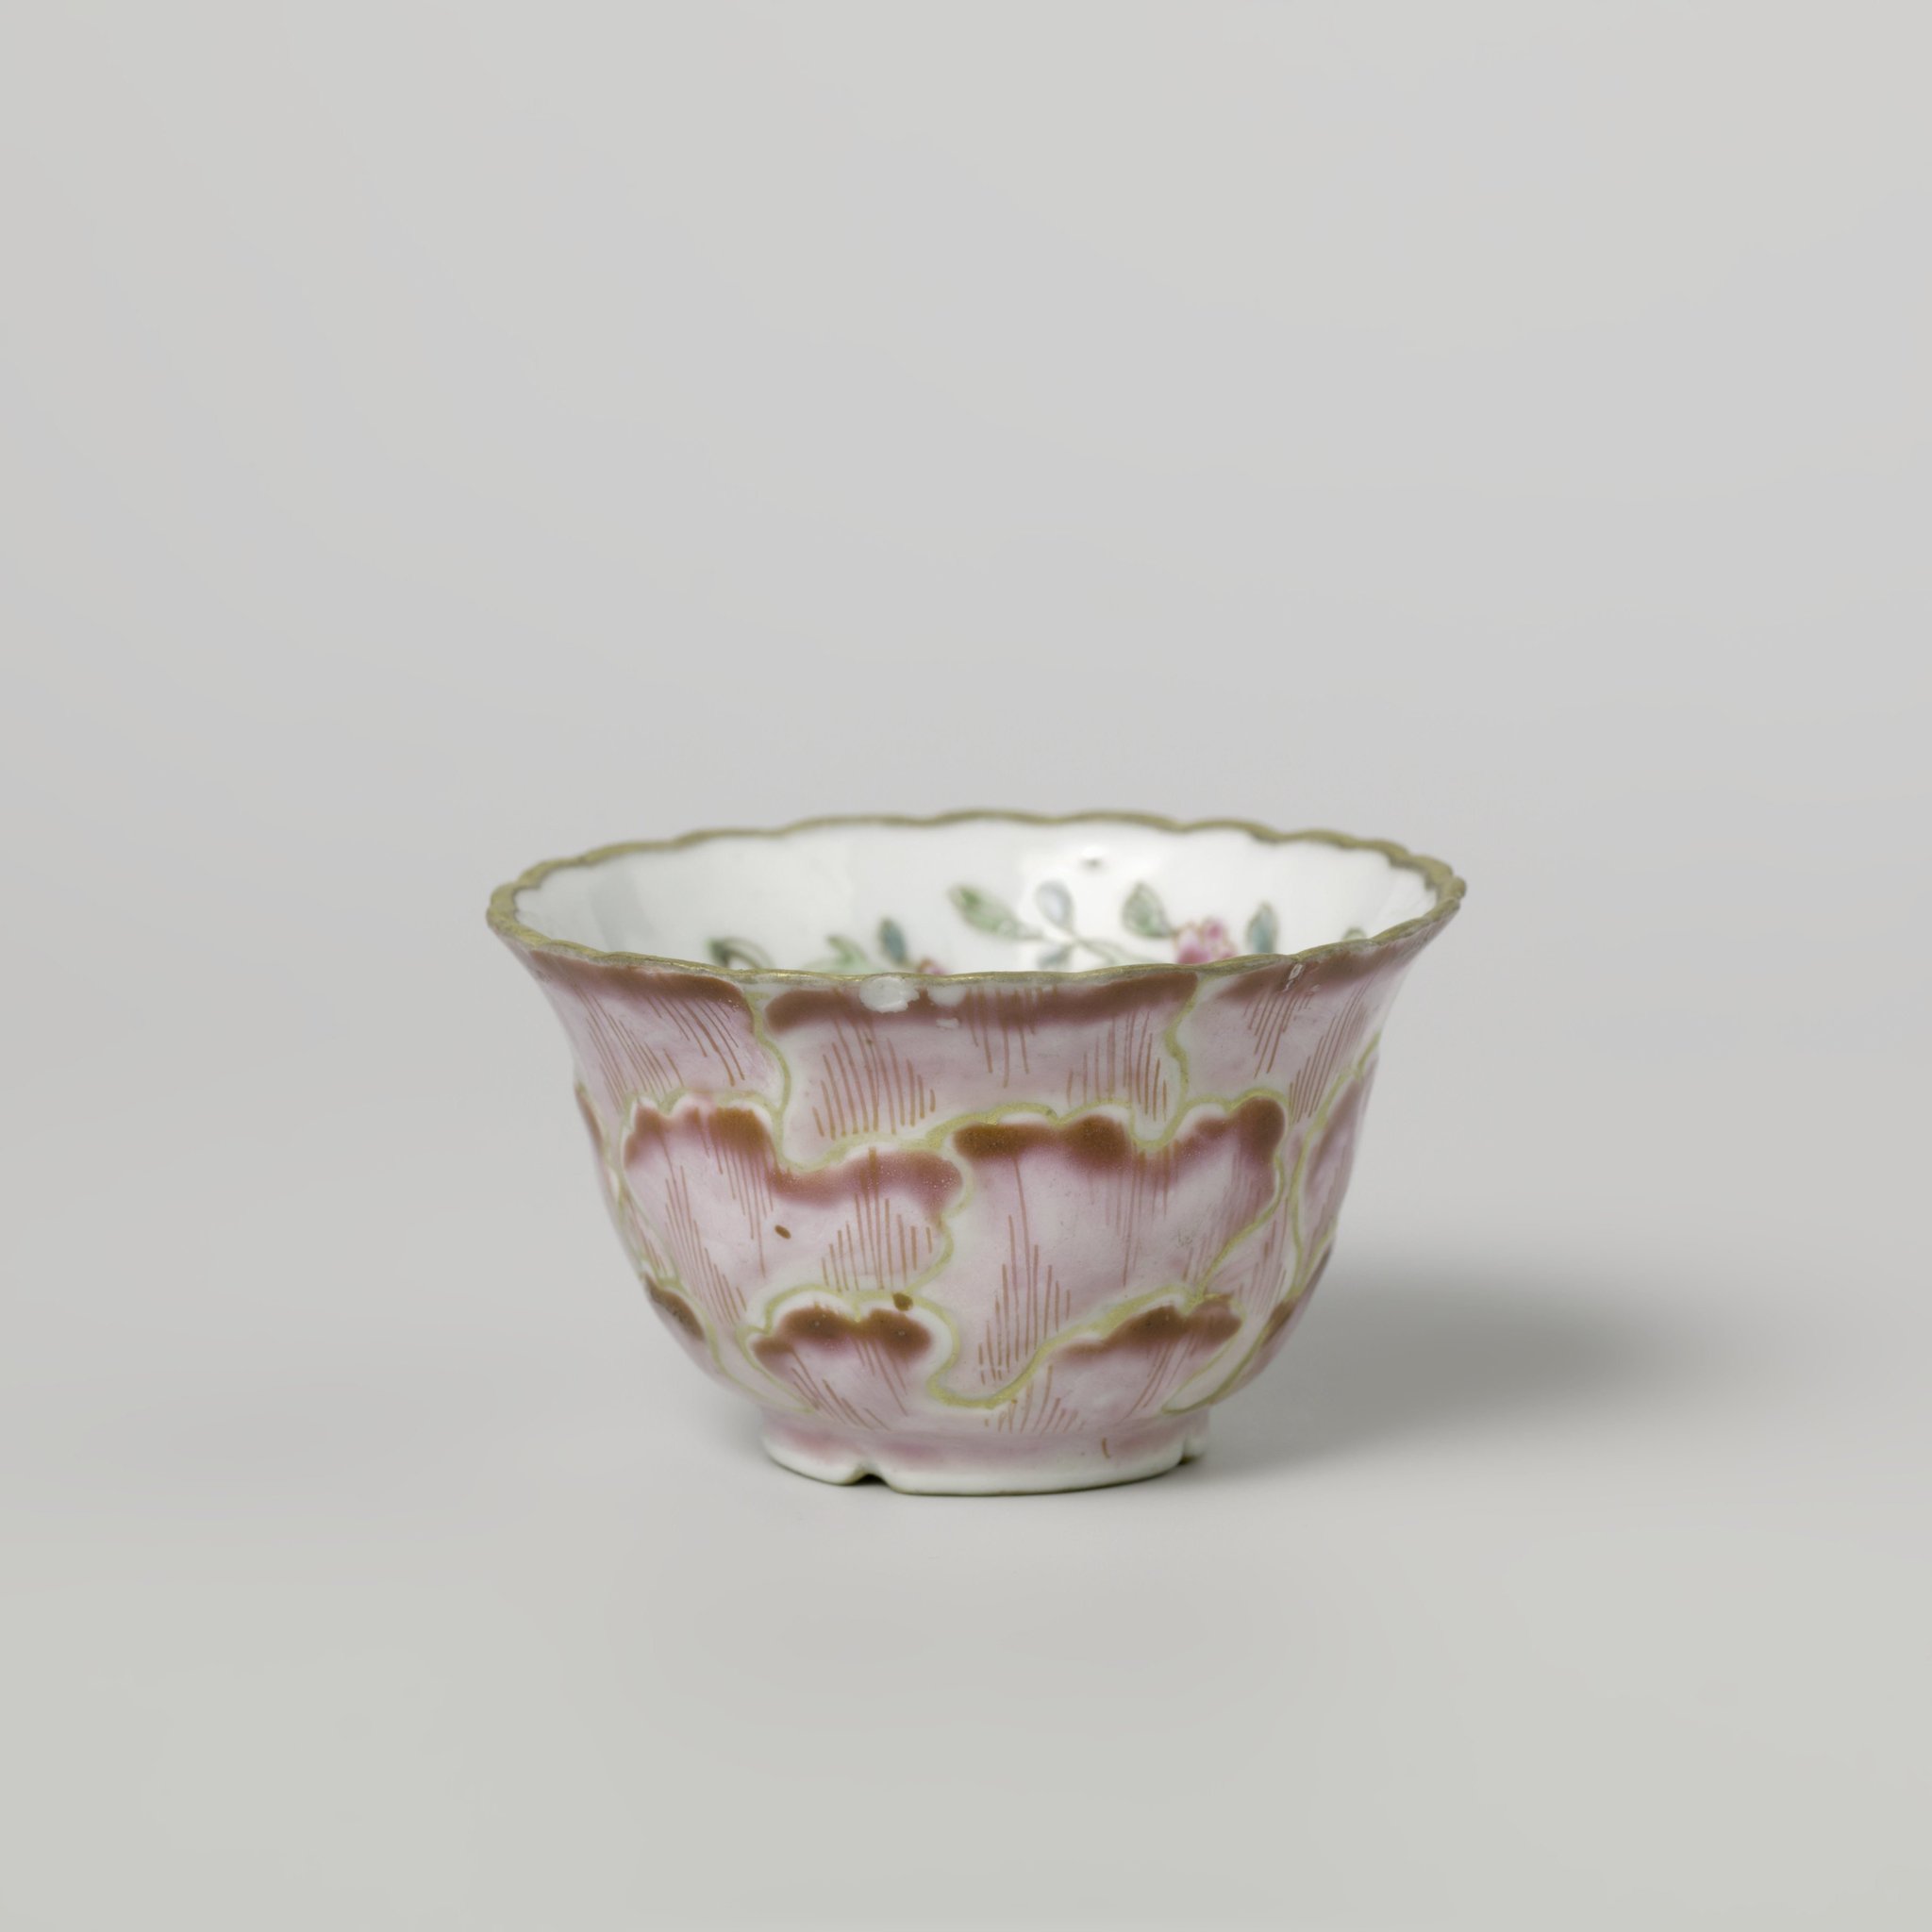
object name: cup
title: Bell-shaped cup modelled in the shape of a flower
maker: Anonymous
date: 1740-1760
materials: glaze, gold, paint, porcelain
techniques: firing, gilding, turning, vitrification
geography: china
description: AK-NM-6406 en 6407 Zes koppen en schotels • Famille rose porselein • Onderdeel van Royers porseleincollectie • Mogelijk afkomstig van Susanna Louise Huygens De koppen en schotels zijn gevormd als zich openende bloemblaadjes en de stengels en blaadjes vormen de voet van de schotels. Het navolgen van elementen uit de natuur kwam bij het vormen van keramiek in China vaker voor. Royer had daar zelf voorbeelden van bij zijn Yixing theepotten (AK-NM-6568 en -6580 bijvoorbeeld) en bij zijn blanc de Chine porselein (de bakjes AK-NM-6534). Dit soort theegoed dat in vrij veel andere collecties ook te vinden is en waar dus blijkbaar enthousiasme voor bestond onder de Europese kopers, volgt hetzelfde principe, maar is verder gestandaardiseerd en – mede door de beschildering – een tikje kitschiger [Wirgin 1998, nr. 93]. Opvallend is dat juist ook in vorstelijke collecties deze koppen en schotels te vinden zijn: in Londen, Dresden, Kopenhagen [Ayers 2016, vol. I, nrs. 761-766, Reichel 1993, nr. 28, Grandjean 1965, nr. 12, pl. 28]. Informatie over die vorstelijke collecties helpt bij het dateren. In Dresden werden de kopjes tussen 1727 en 1729 geïnventariseerd en in Kopenhagen hebben ze een monogram van koning Christiaan VI die van 1730 tot 1746 regeerde. Ze zijn dus vroeger dan je zou denken. Royer kon ze waarschijnlijk in 1786 overnemen uit de nalatenschap van zijn oudtante Susanna Louise Huygens (1714-1785). In de beschrijving van haar gekleurde porselein vinden we ‘ses paar thee goed, van buiten rood, schulpwerk, en van binnen marseille met bouquetten, de schoteltjes met geboutzeer rankwerk.’ Deze koppen en schotels horen dus bij de porseleinverzameling. Dit in tegenstelling tot de vele koffie- en theeserviezen en losse series theegoed die volgens de boedelbeschrijving opgemaakt na het overlijden van de weduwe Royer, ergens een plek in huis hadden. Bronnen: Bredo L. Grandjean, Dansk Ostindisk porcelaen importen fra Kanton ca. 1700-1822, Kopenhagen, 1965. Friedrich Reichel, Die Porzellansammlung Augusts des Starken: Porzellankunst aus China, die rosa Familie, München, 1993. Jan Wirgin, Fran Kina till Europa. Kinesiska konstföremal fran de ostindiska kompaniernas tid, Stockholm, 1998. John Ayers, Chinese and Japanese works of art in the collection of Her Majesty The Queen, Londen, 2016.